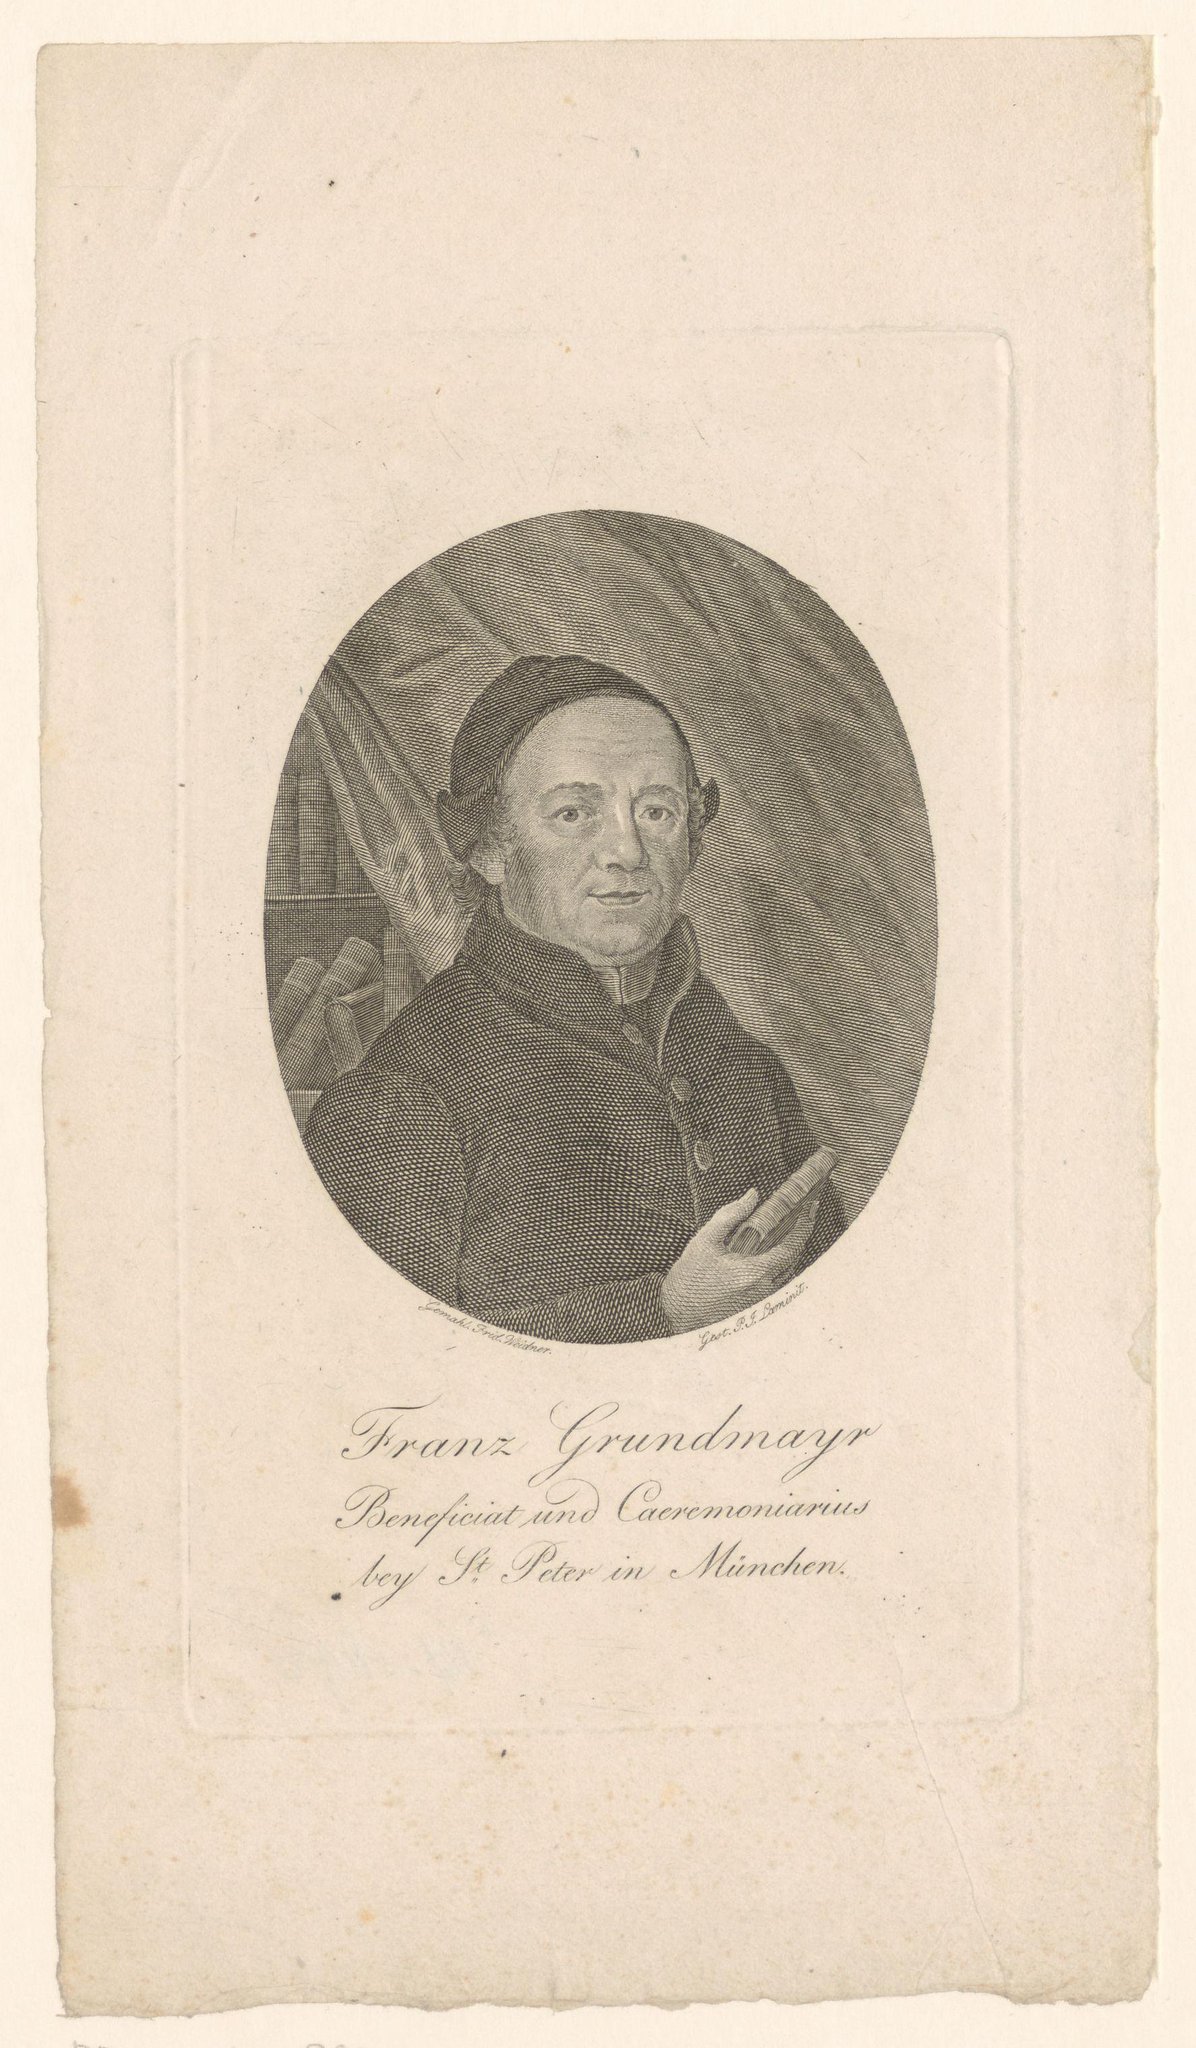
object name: print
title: Portret van Franz Grundmayr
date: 1783-1831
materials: paper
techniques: engraving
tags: theologian, historical persons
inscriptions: collector's mark: Lugt 2228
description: Een facsimile signatuur in de ondermarge.